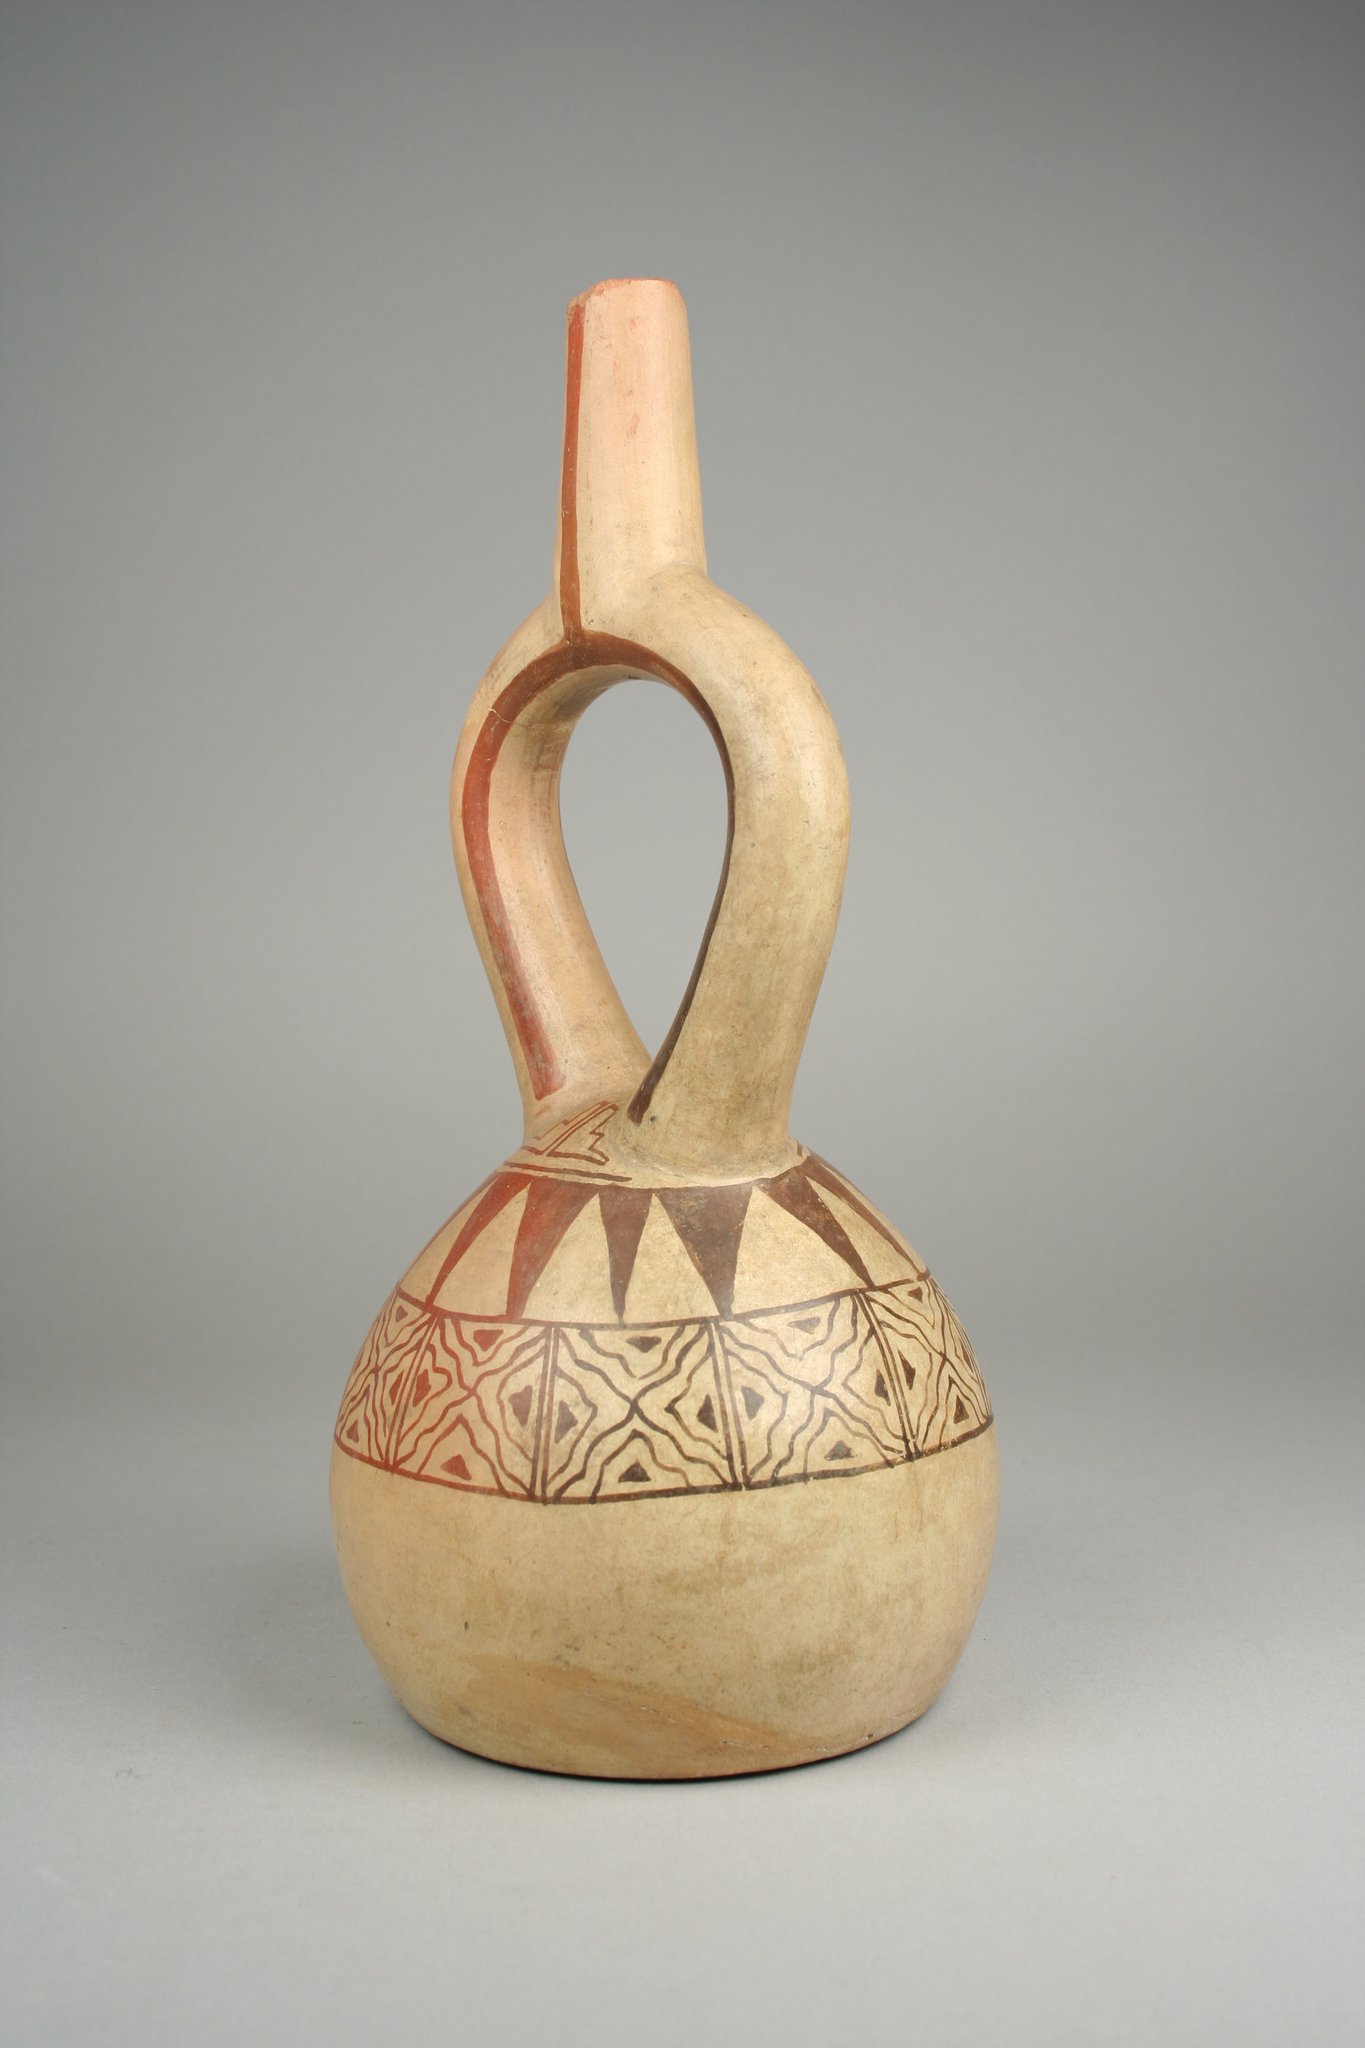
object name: bottle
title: Geometric Pattern Bottle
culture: moche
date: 301-700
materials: ceramic, pigment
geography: peru